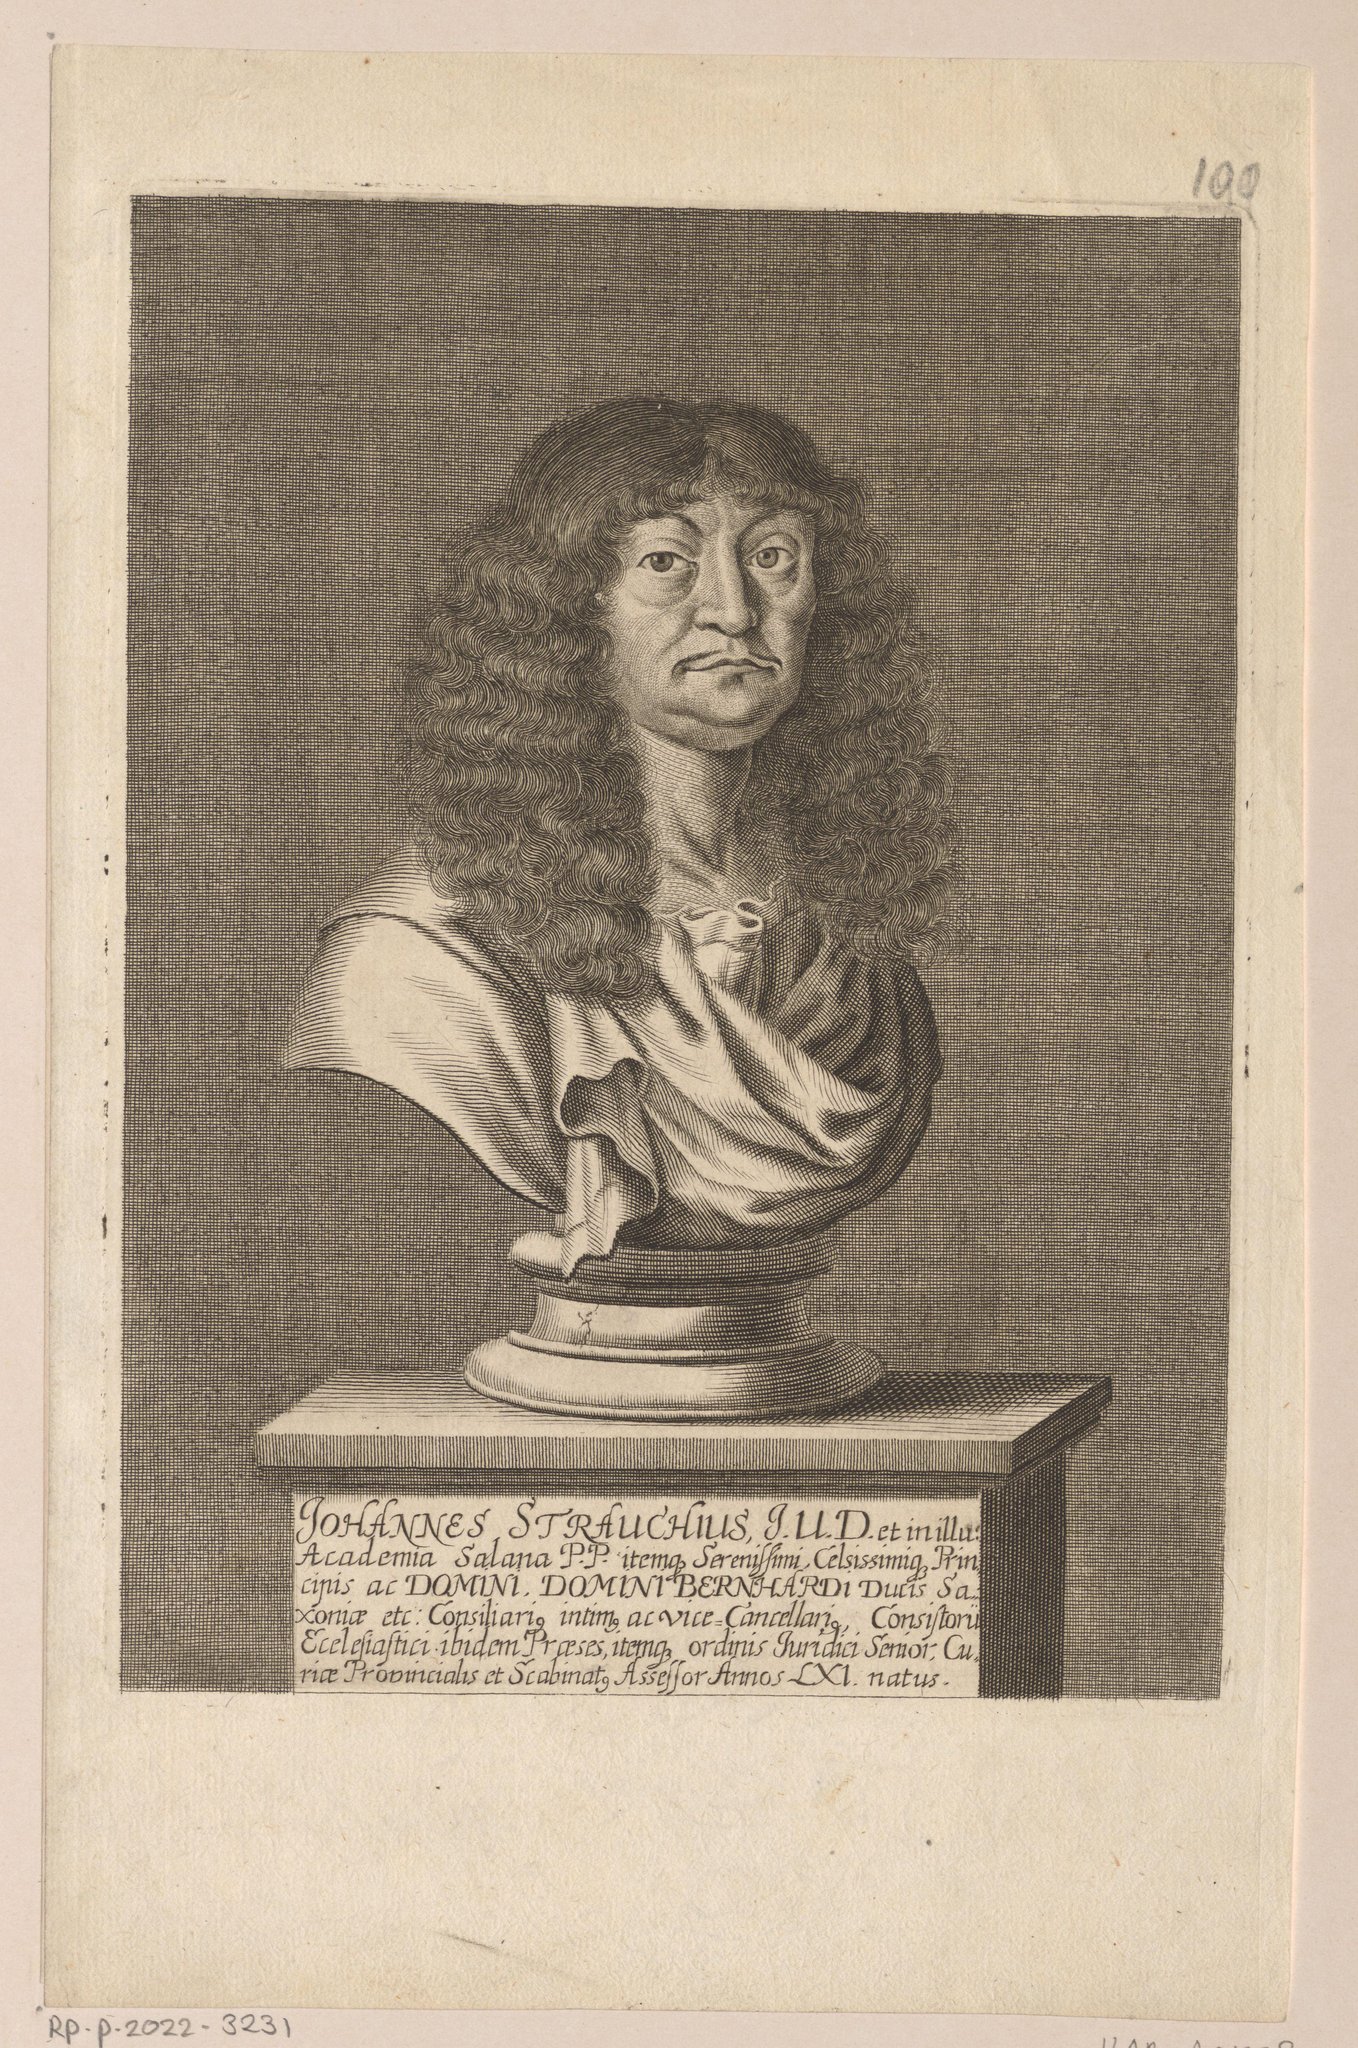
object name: print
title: Portret van Johann Strauch op 61-jarige leeftijd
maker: Anonymous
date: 1673-1699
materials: paper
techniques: engraving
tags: johann strauch, historical persons, portrait of a writer, professor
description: Met zesregelig onderschrift in het Latijn.